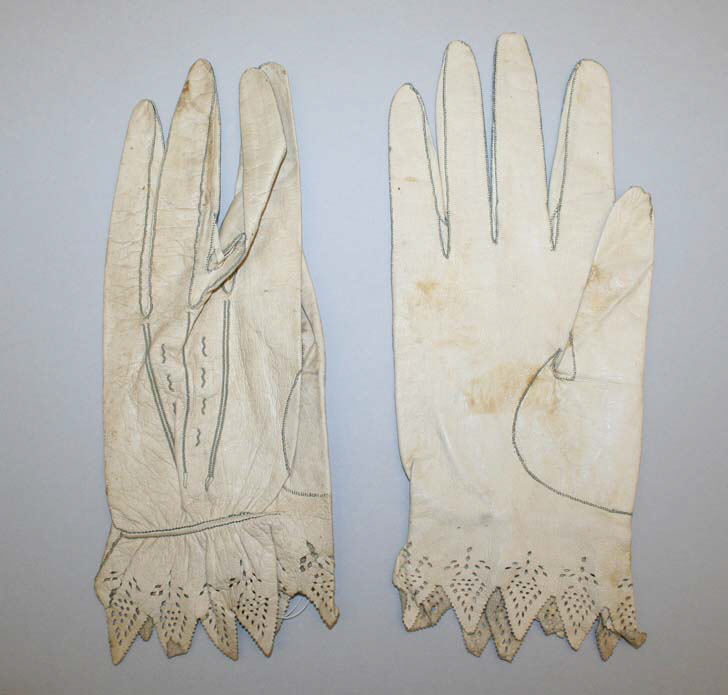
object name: glove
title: Gloves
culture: american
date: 1876-1900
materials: leather